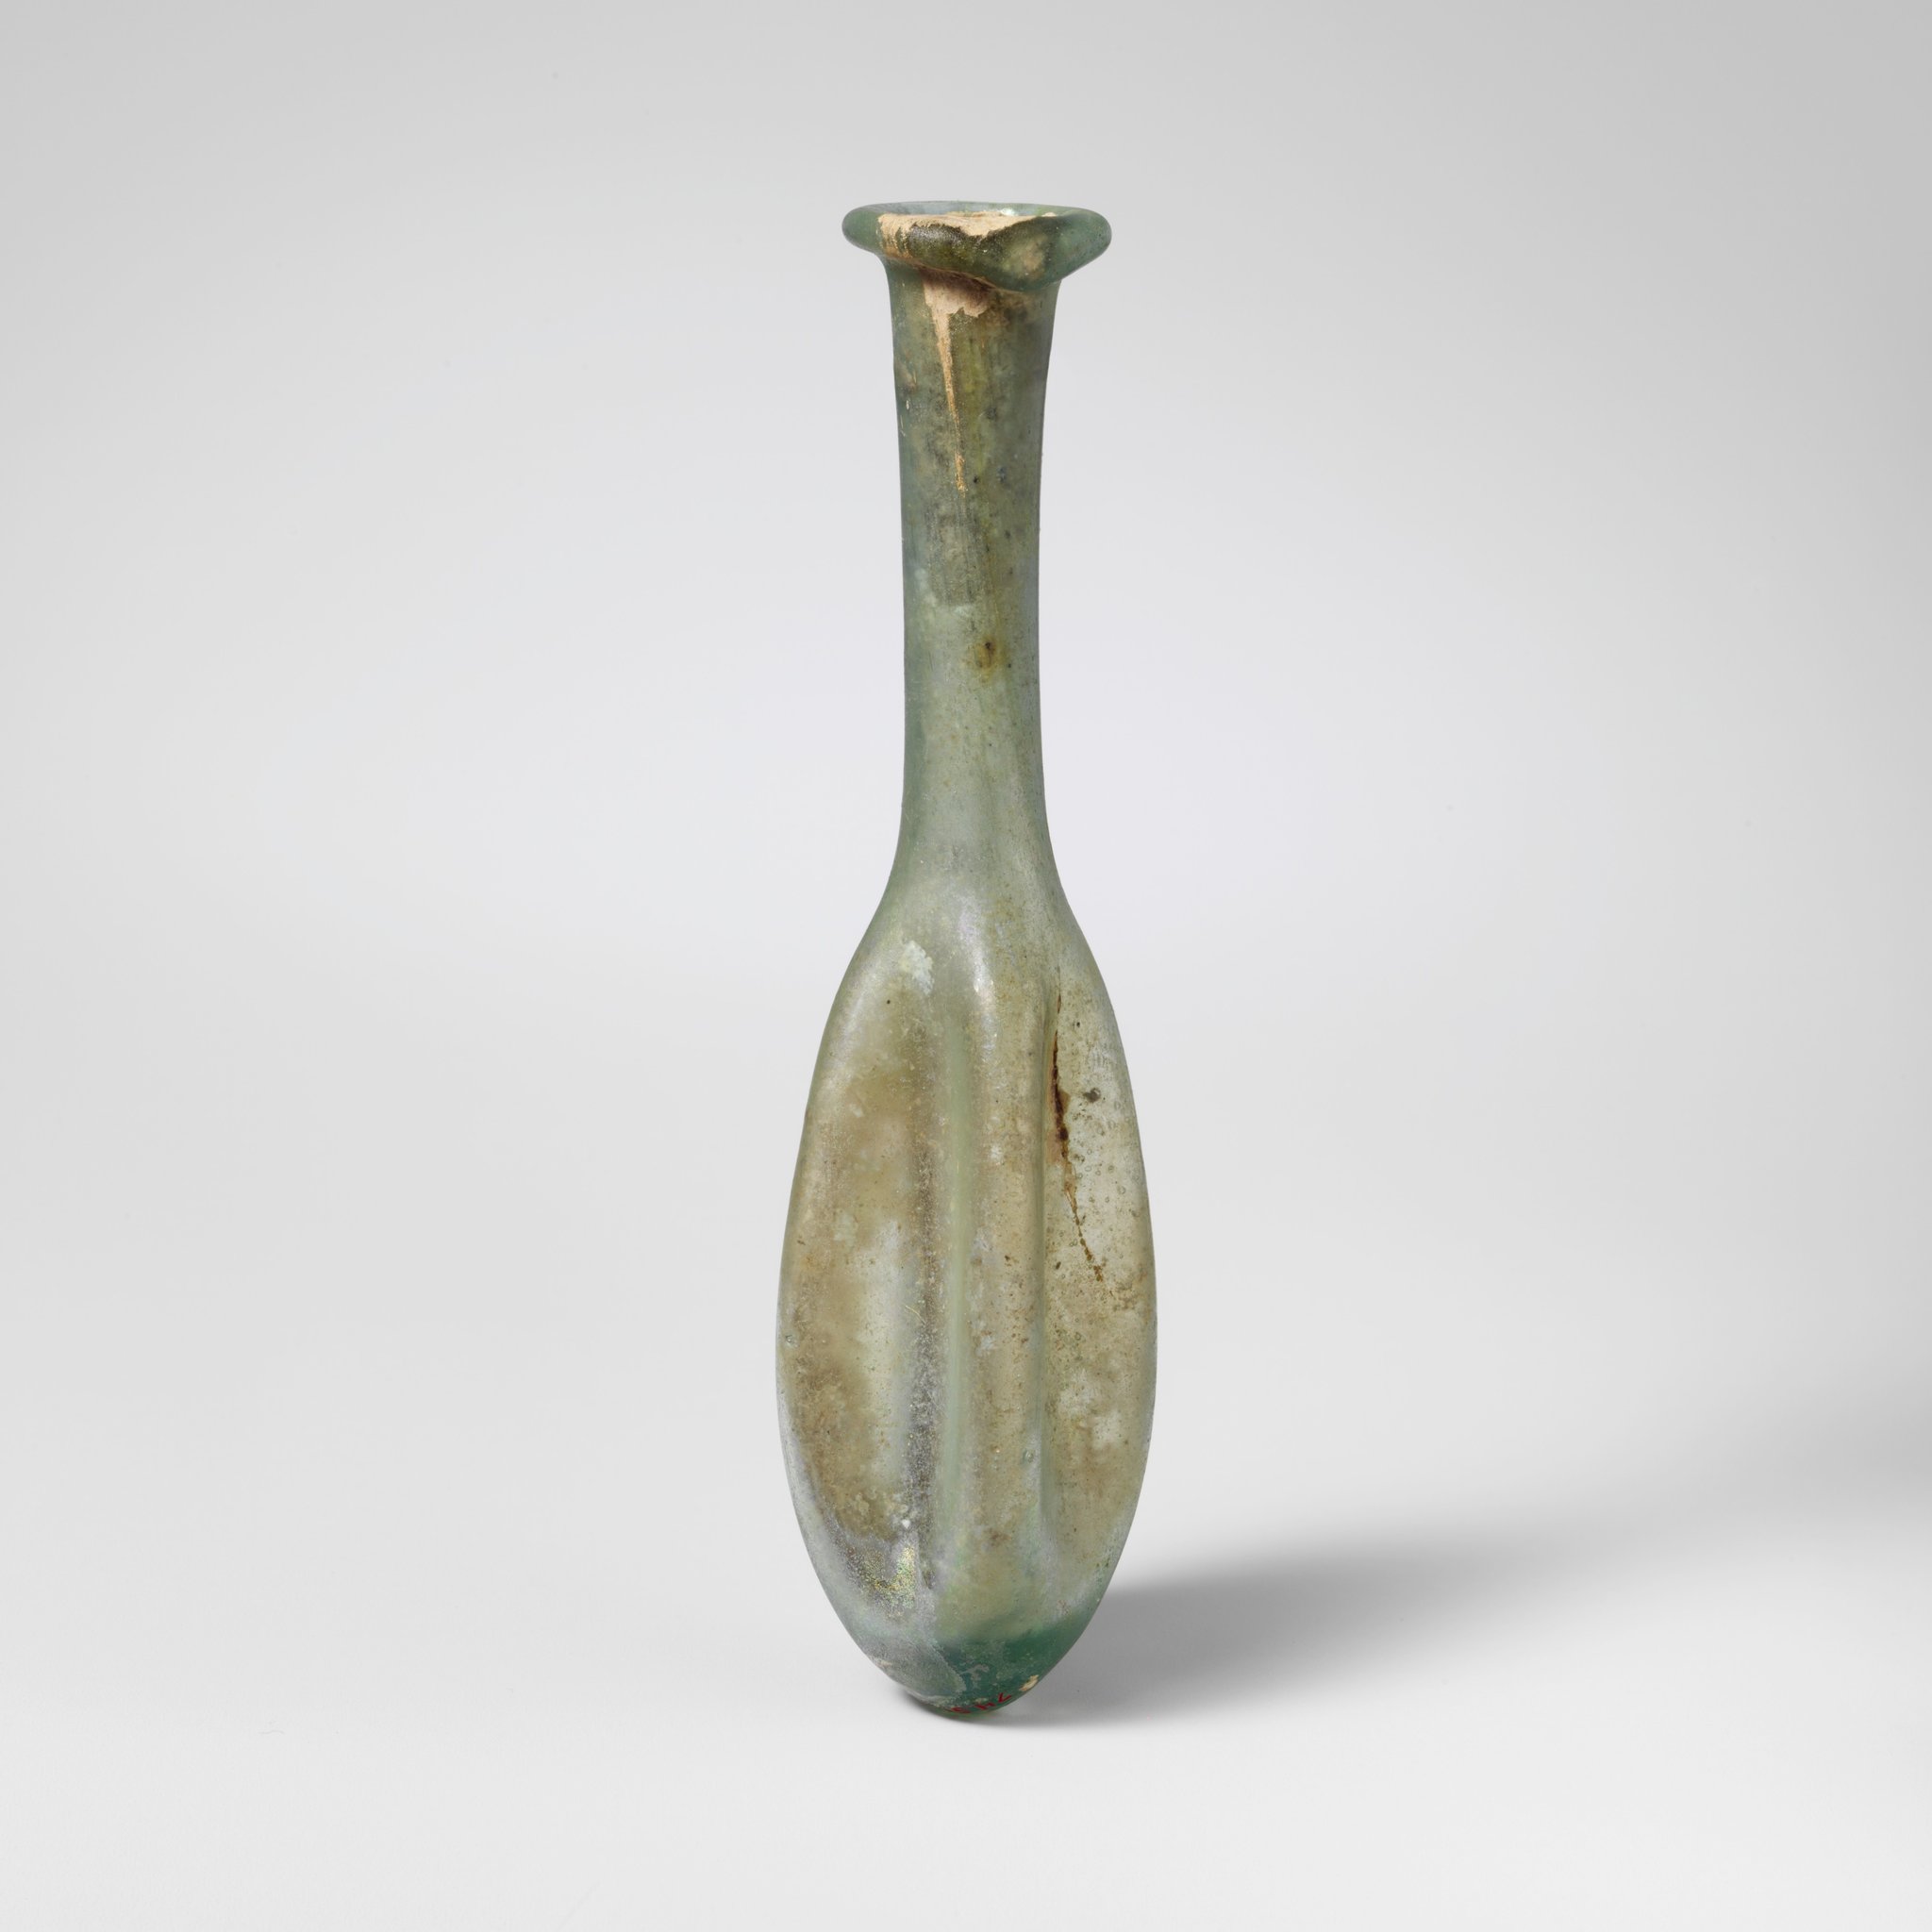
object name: bottle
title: Glass perfume bottle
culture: roman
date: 101-300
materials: glass